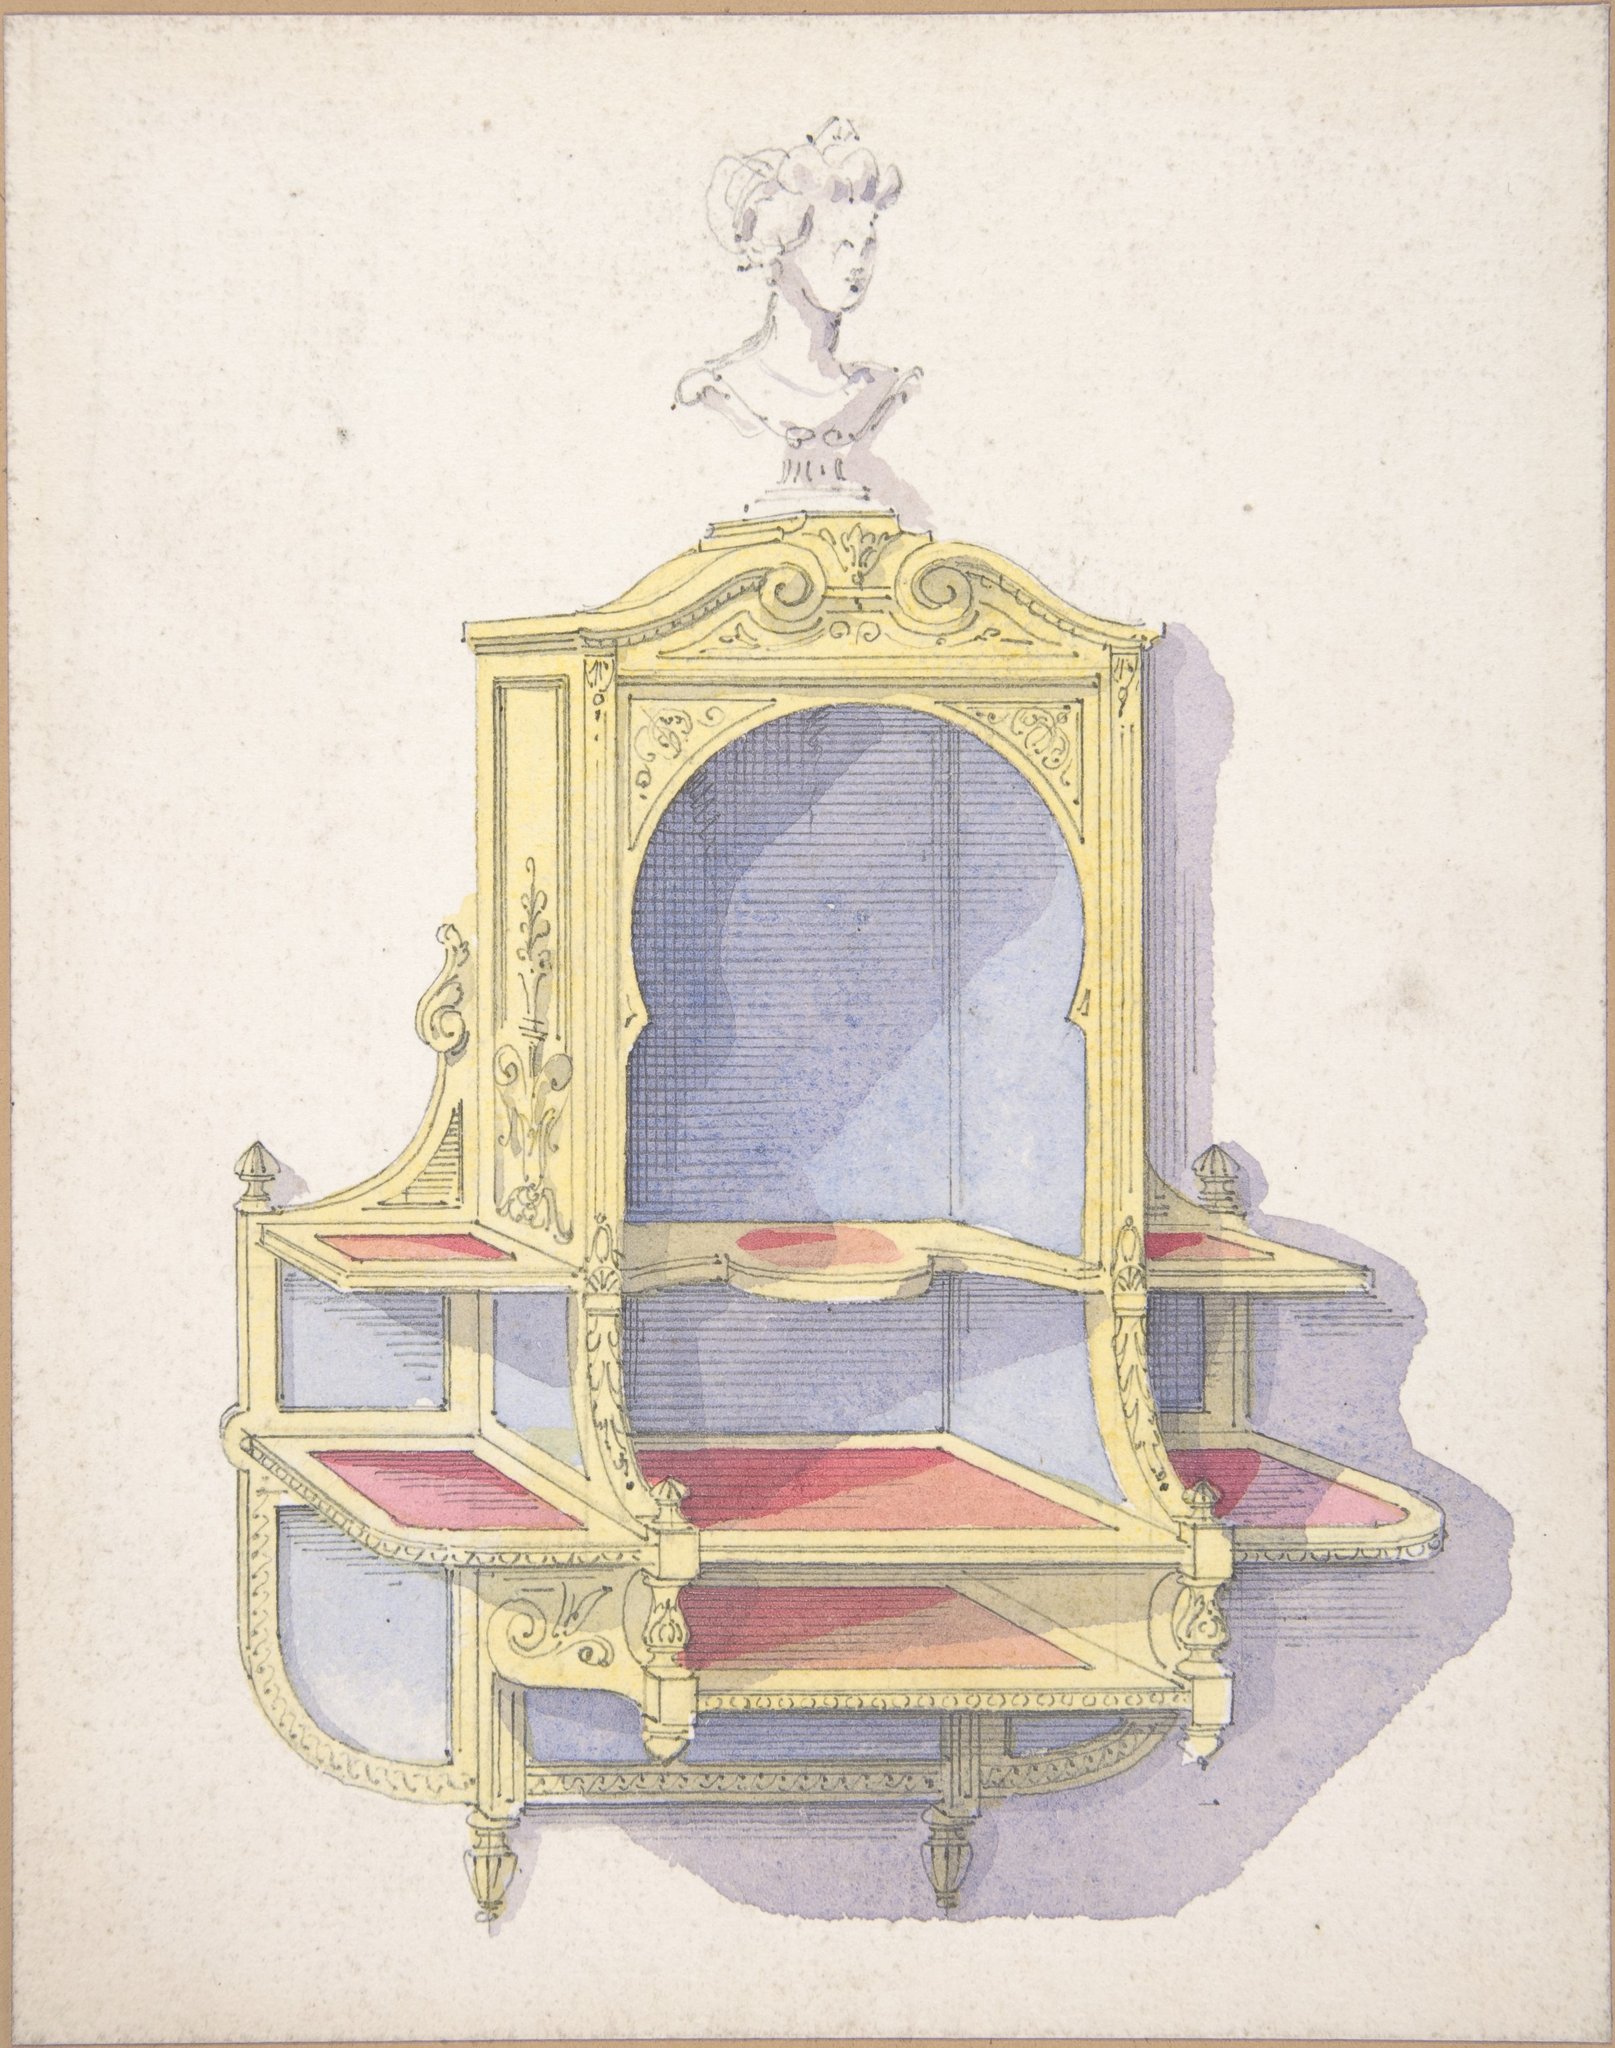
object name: drawing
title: Design for Hanging Shelves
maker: anonymous, british, 19th century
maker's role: artist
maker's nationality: british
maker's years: 1800-1900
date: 1840-1899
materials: gouache, ink, watercolor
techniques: pen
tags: heads,furniture